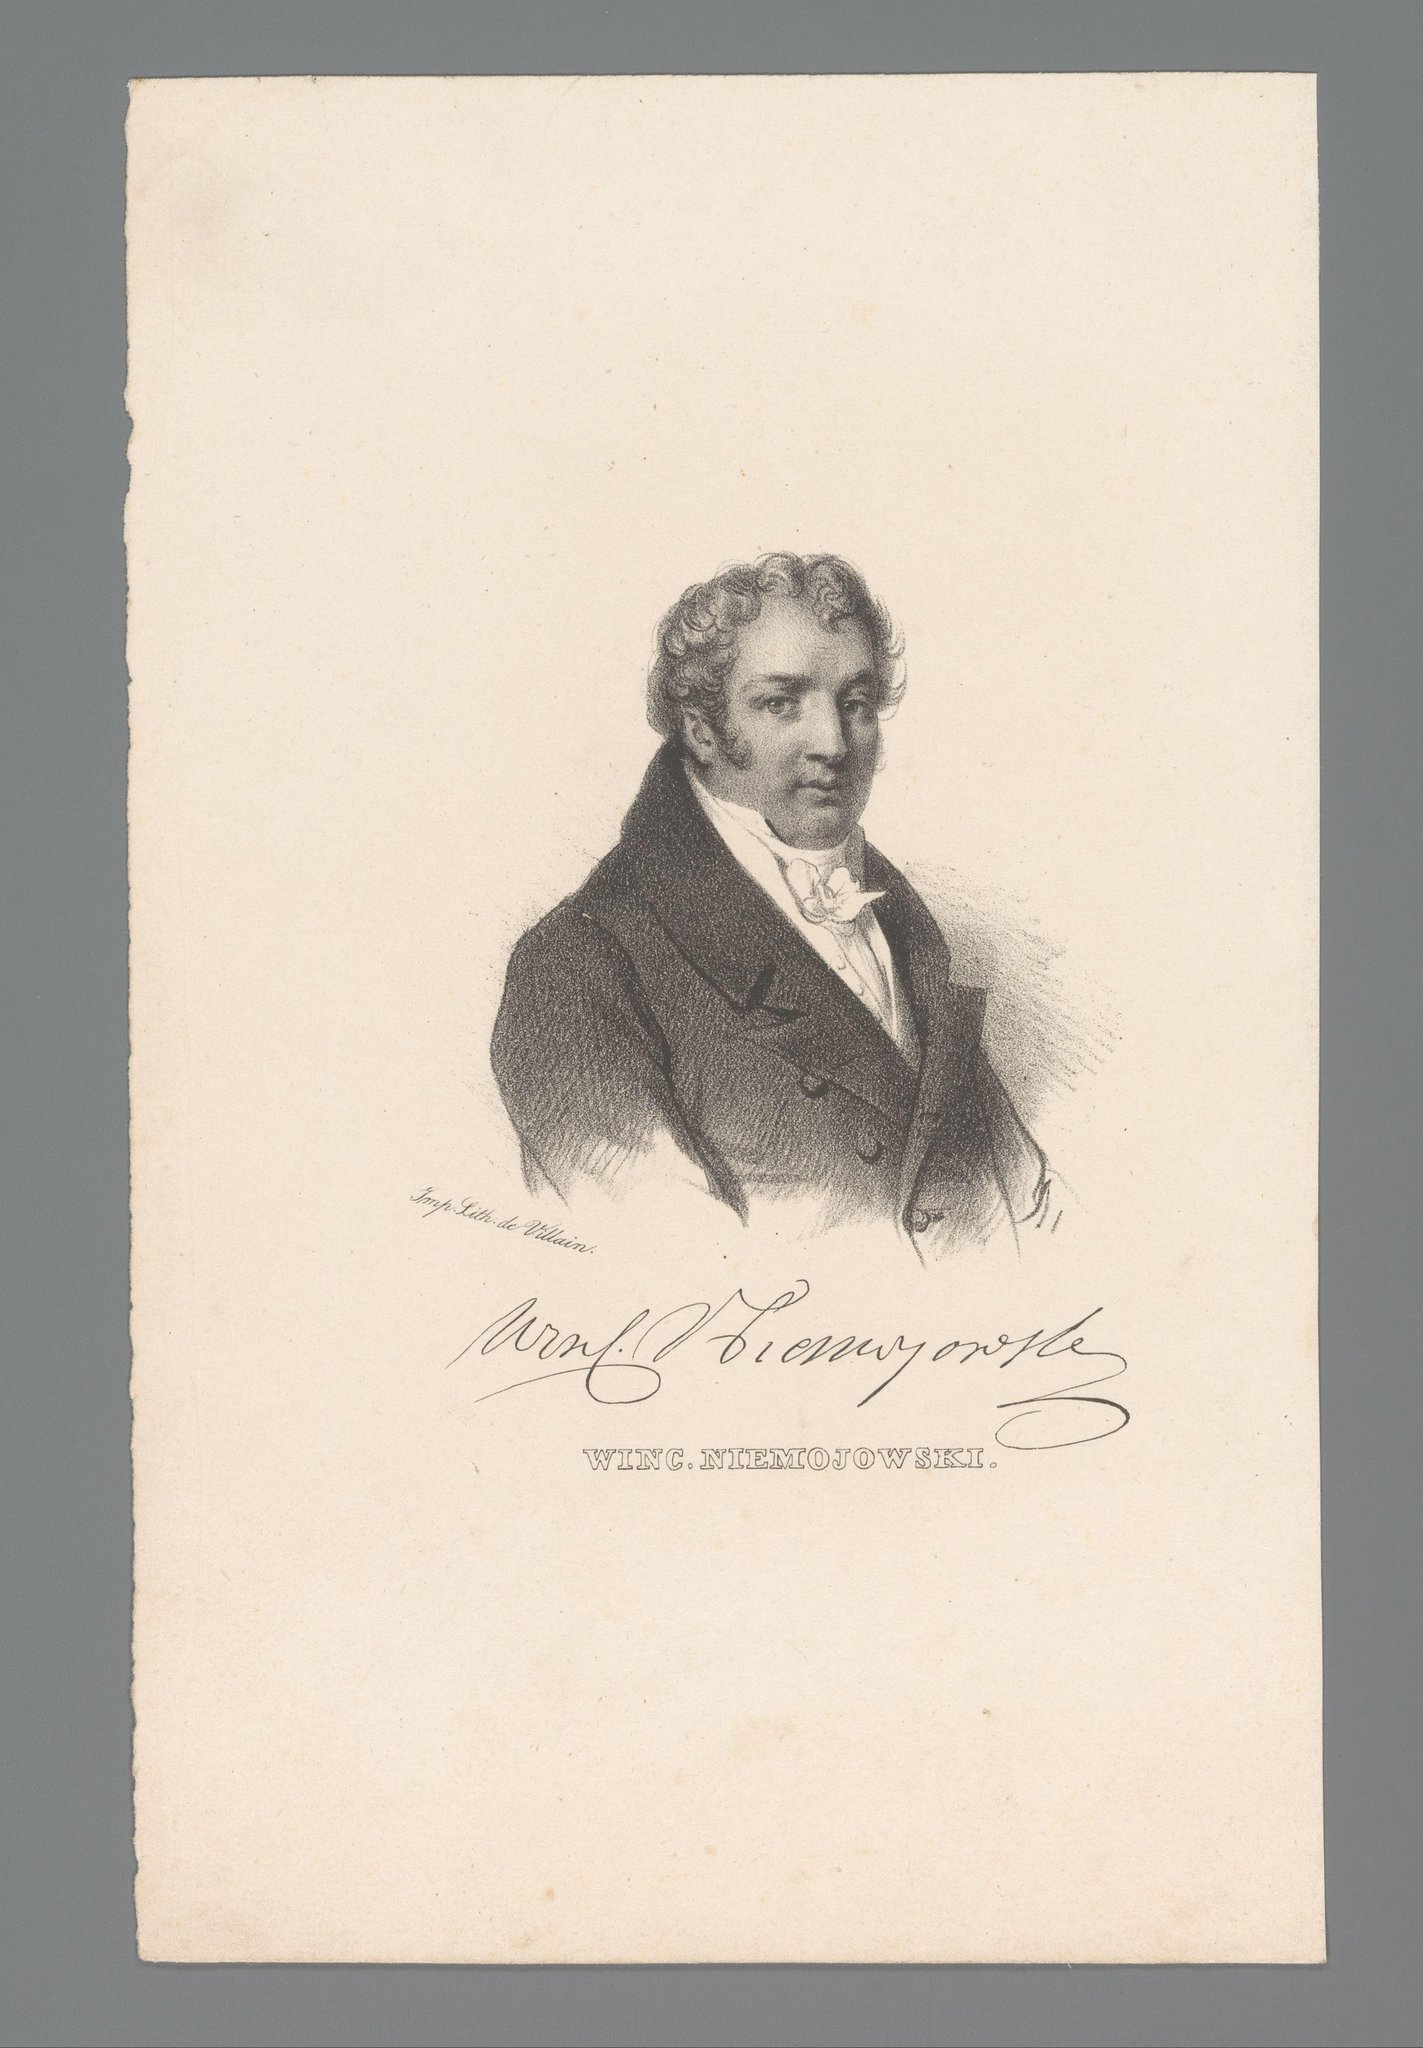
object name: print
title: Winc. Niemojowski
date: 1832-1839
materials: paper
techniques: lithograph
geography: paris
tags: politician, historical persons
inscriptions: collector's mark: Lugt 2228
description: Prent uit: Straszewicz., Joseph. Les polonais et les polonaises de la révolution du 29 novembre 1830, ou Portraits des personnes qui ont figuré dans la dernière guerre de l'indépendance polonaise, avec les fac-simile de leur signature, lithographiés sur dessins originaux, par les artistes les plus distingués: MM. Grévedon, Maurin, Vigneron, Belliard, Devéria, Bazin, Desmadryl, Lecler, Desmaisons, Rutowski, officier polonais, etc,. etc., accompagnés d'une biographie pour chaque portrait. Parijs: Catherine-Anaïs Pinard, 1832. Of uit: Straszewicz., Joseph. Les polonais et les polonaises de la révolution du 29 novembre 1830. Biographie des personnes qui ont figuré dans la dernière guerre de l'indépendance polonaise, avec les fac-simile de leur signature, ornée de 30 portraits lithographiés sur dessins originaux, par les artistes les plus distingués: MM. Grévedon, Maurin, Vigneron, Belliard, Devéria, Bazin, Desmadryl, Lecler, etc., etc.. Parijs: s.n., 1839.